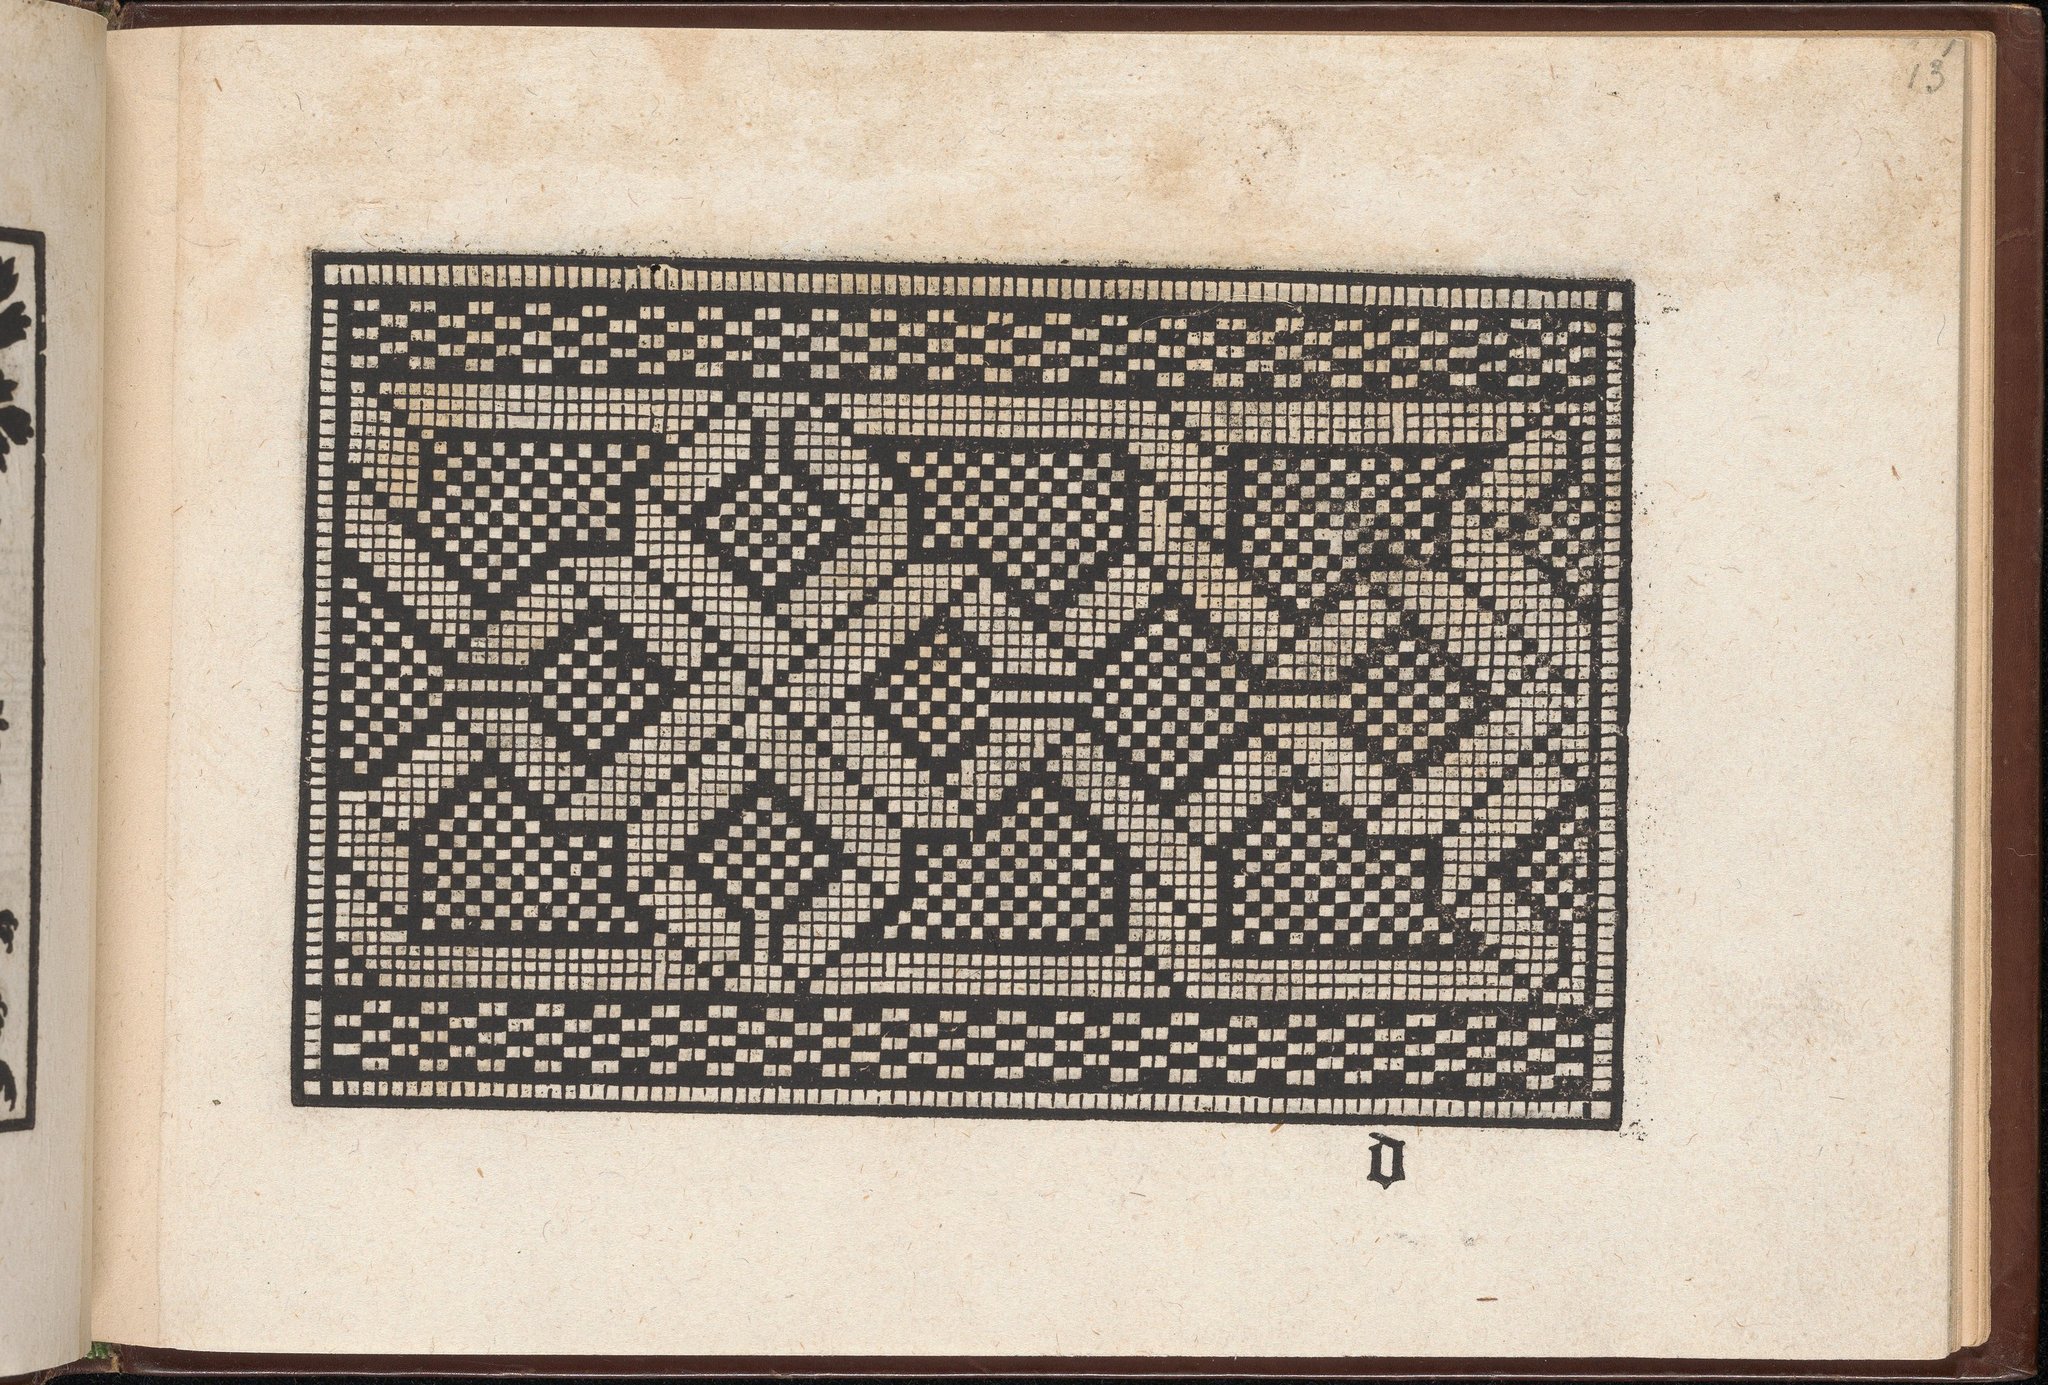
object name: book print ornament architecture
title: Page from Eyn Newe kunstlich moetdelboech alle kunst (Page 13r)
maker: peter quentel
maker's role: publisher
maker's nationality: german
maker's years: 1500-1550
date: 1532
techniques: woodcut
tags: ornament